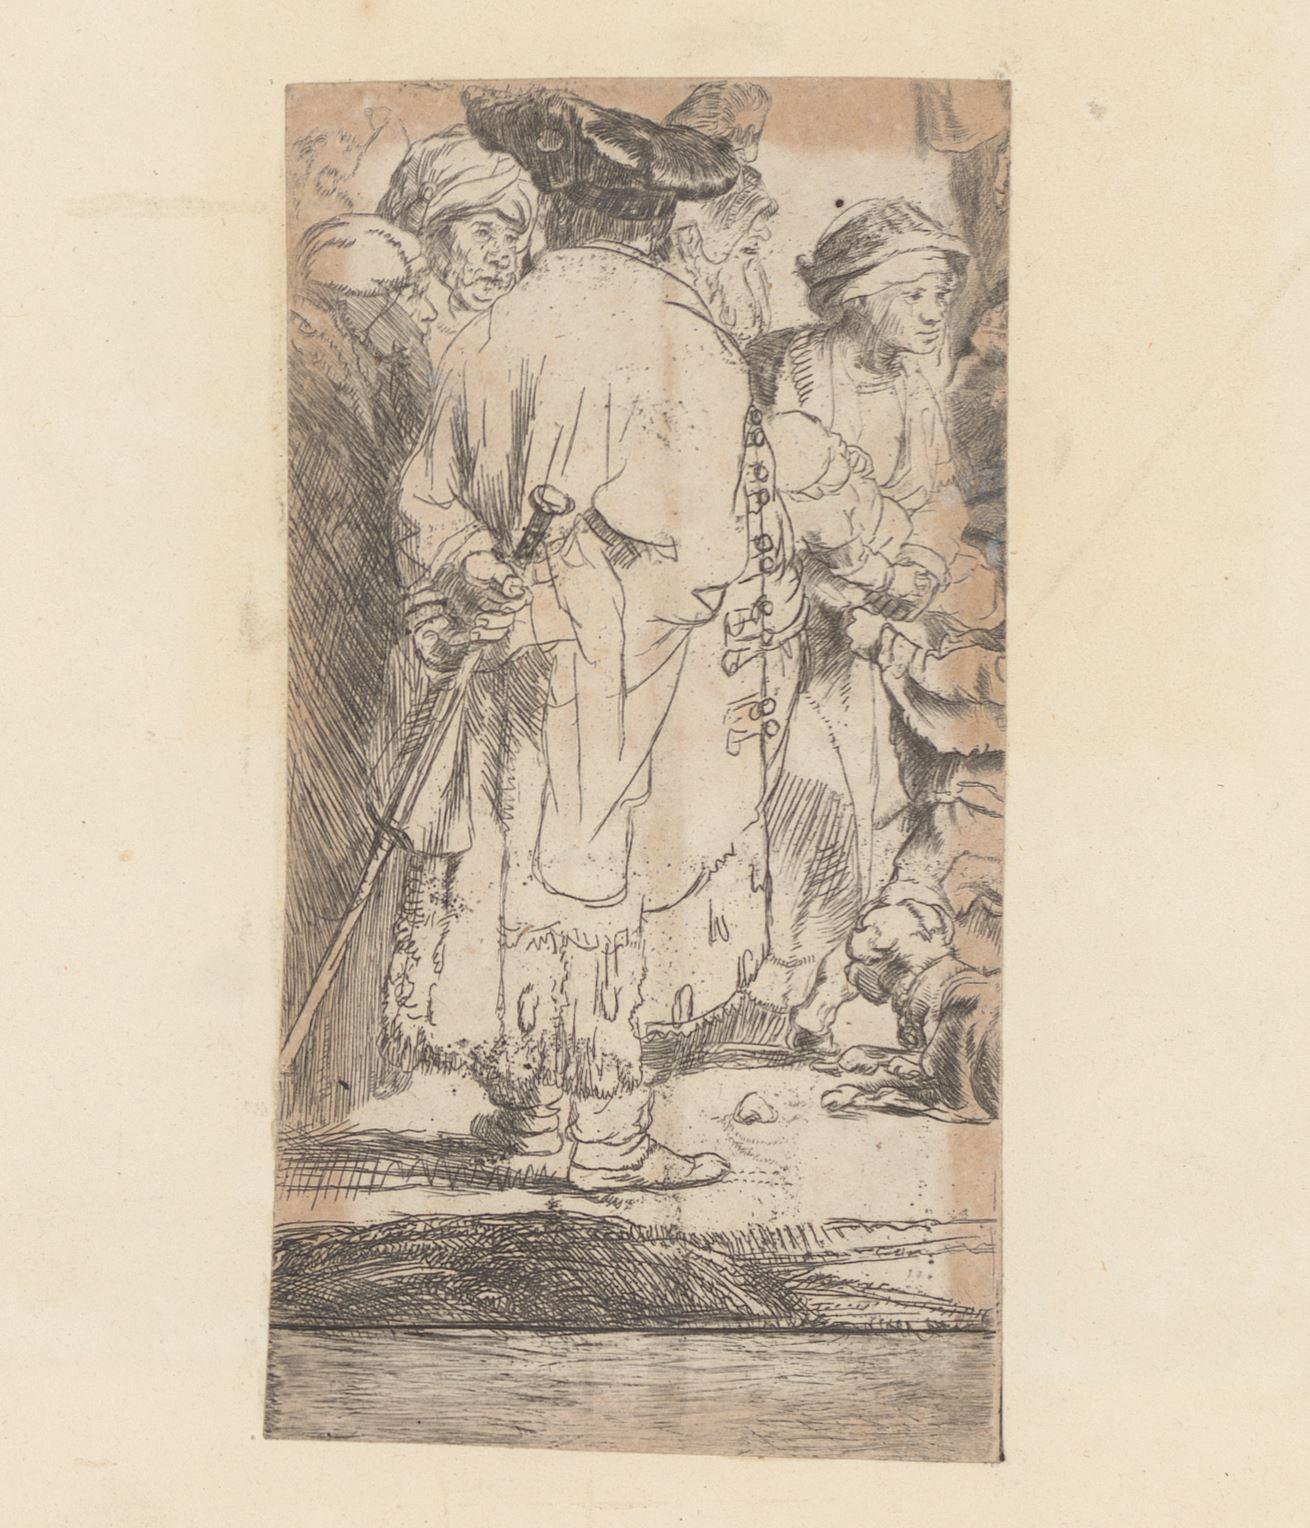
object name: print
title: The Hundred Guilder Print: the man seen on the back in the lower left corner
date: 1753-1810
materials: paper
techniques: drypoint, etching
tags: christ preaching in the open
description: Fragment van versneden plaat van de Honderdguldenprent. De prent maakt deel uit van een album.